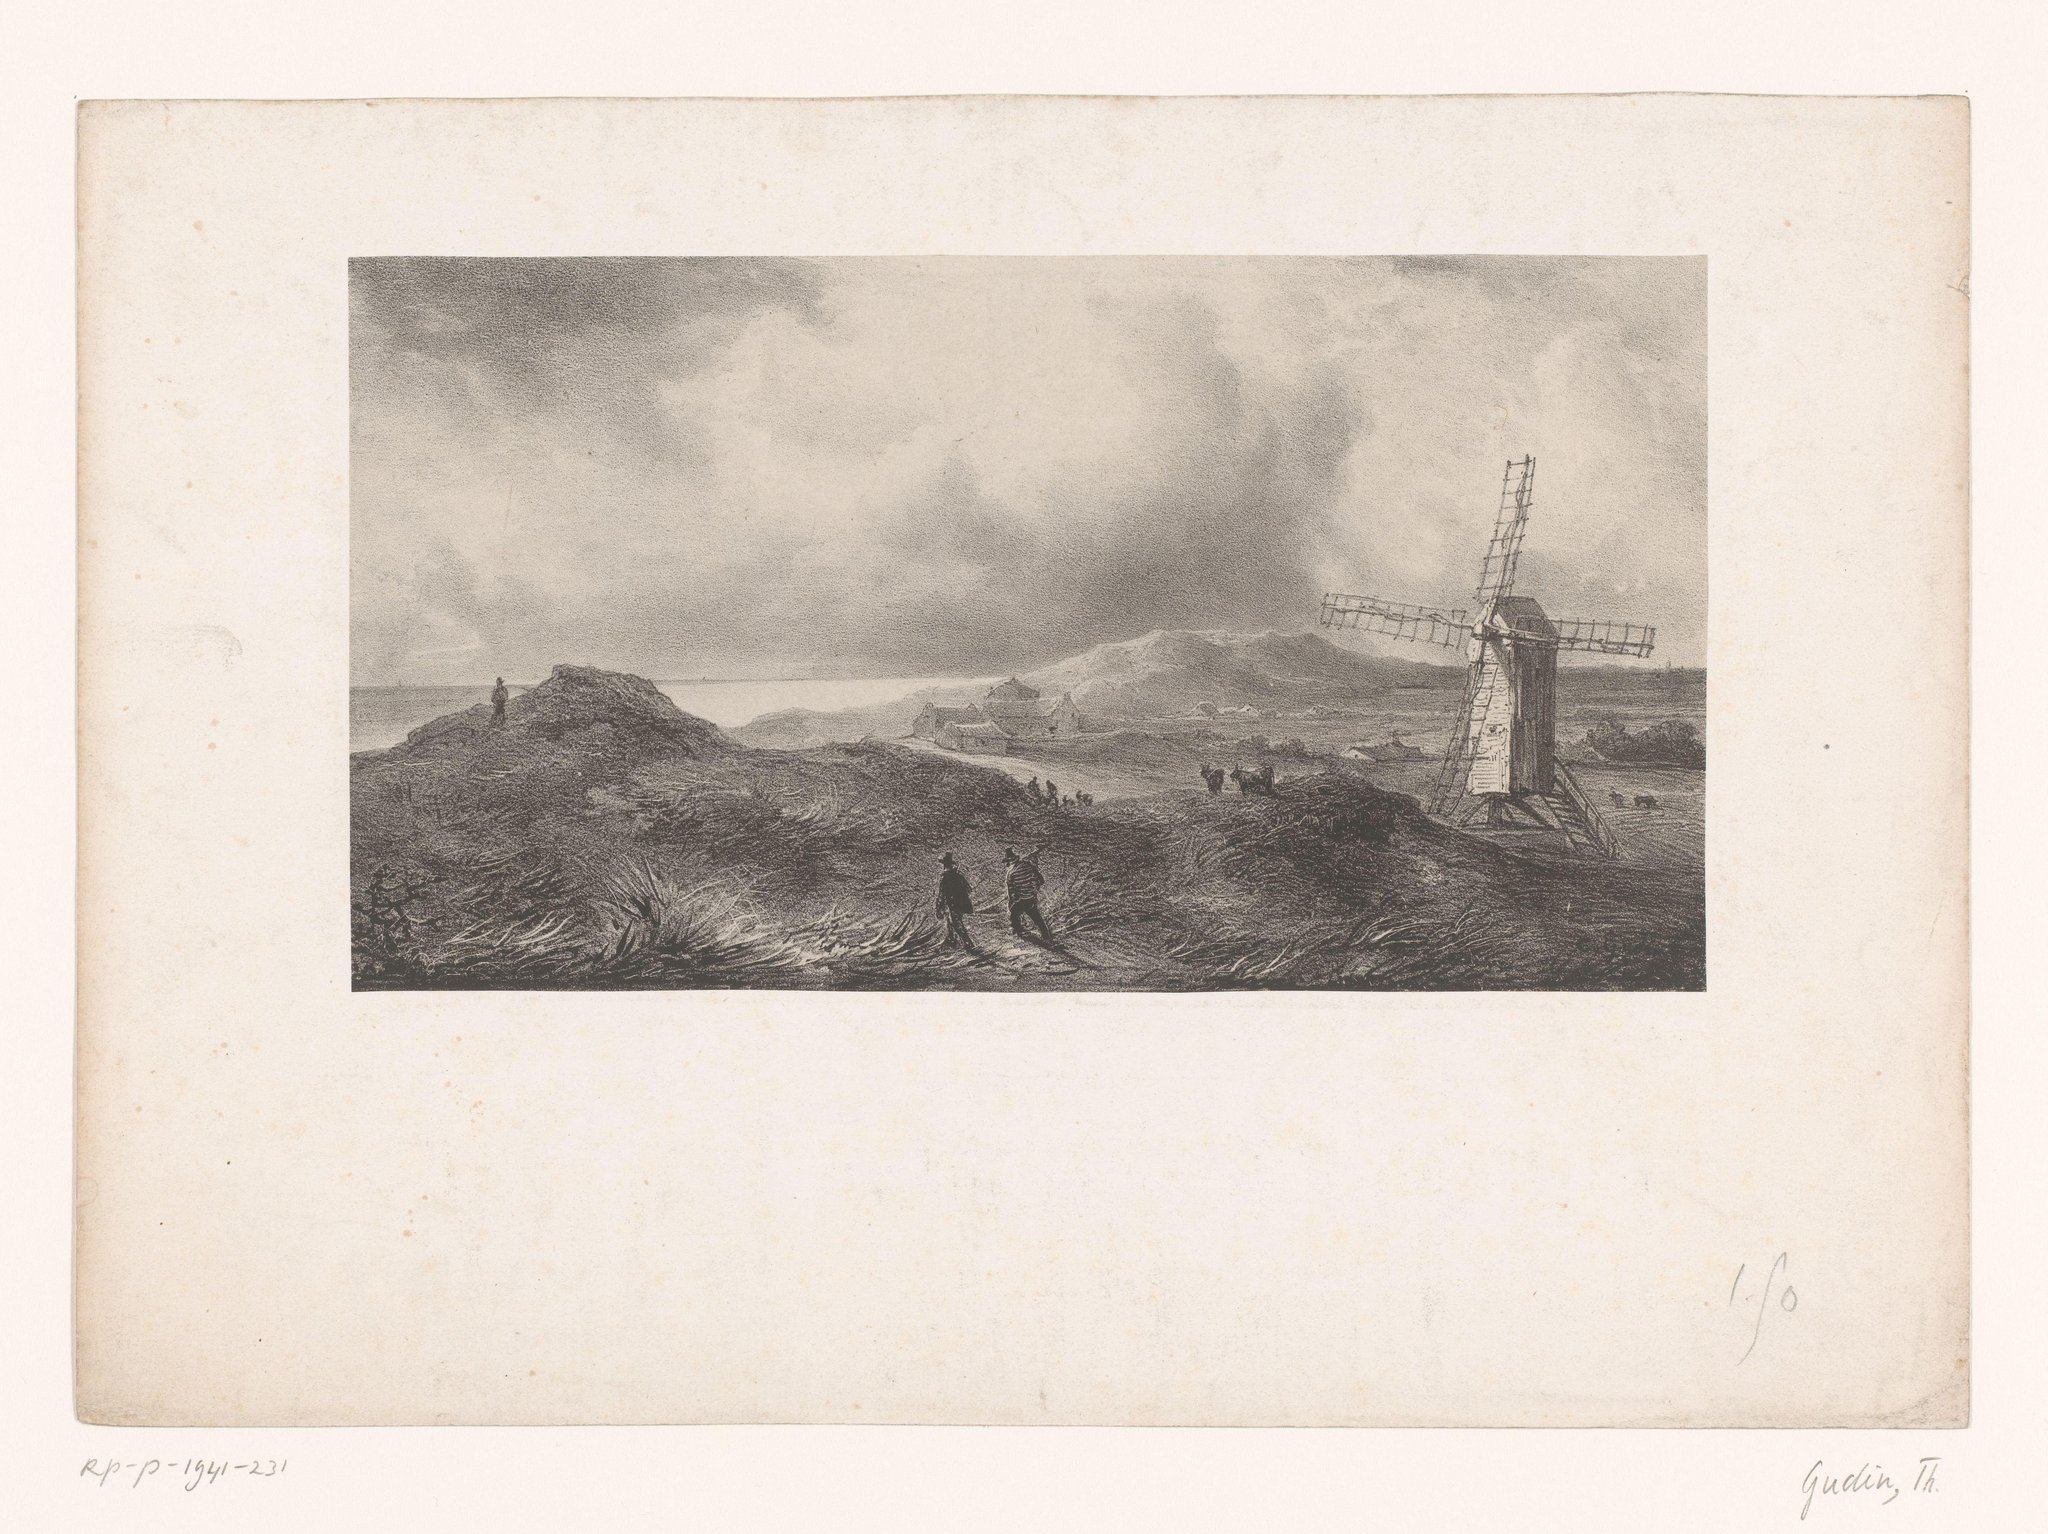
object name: print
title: Duinlandschap met molen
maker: théodore gudin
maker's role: draughtsman, painter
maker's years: 1802-1880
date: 1822-1863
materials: paper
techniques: lithograph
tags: windmill in landscape (+ city(-scape) with figures, staffage), dune coast (+ landscape with figures, staffage)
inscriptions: collector's mark: Lugt 2760, collector's mark: Lugt 2228a